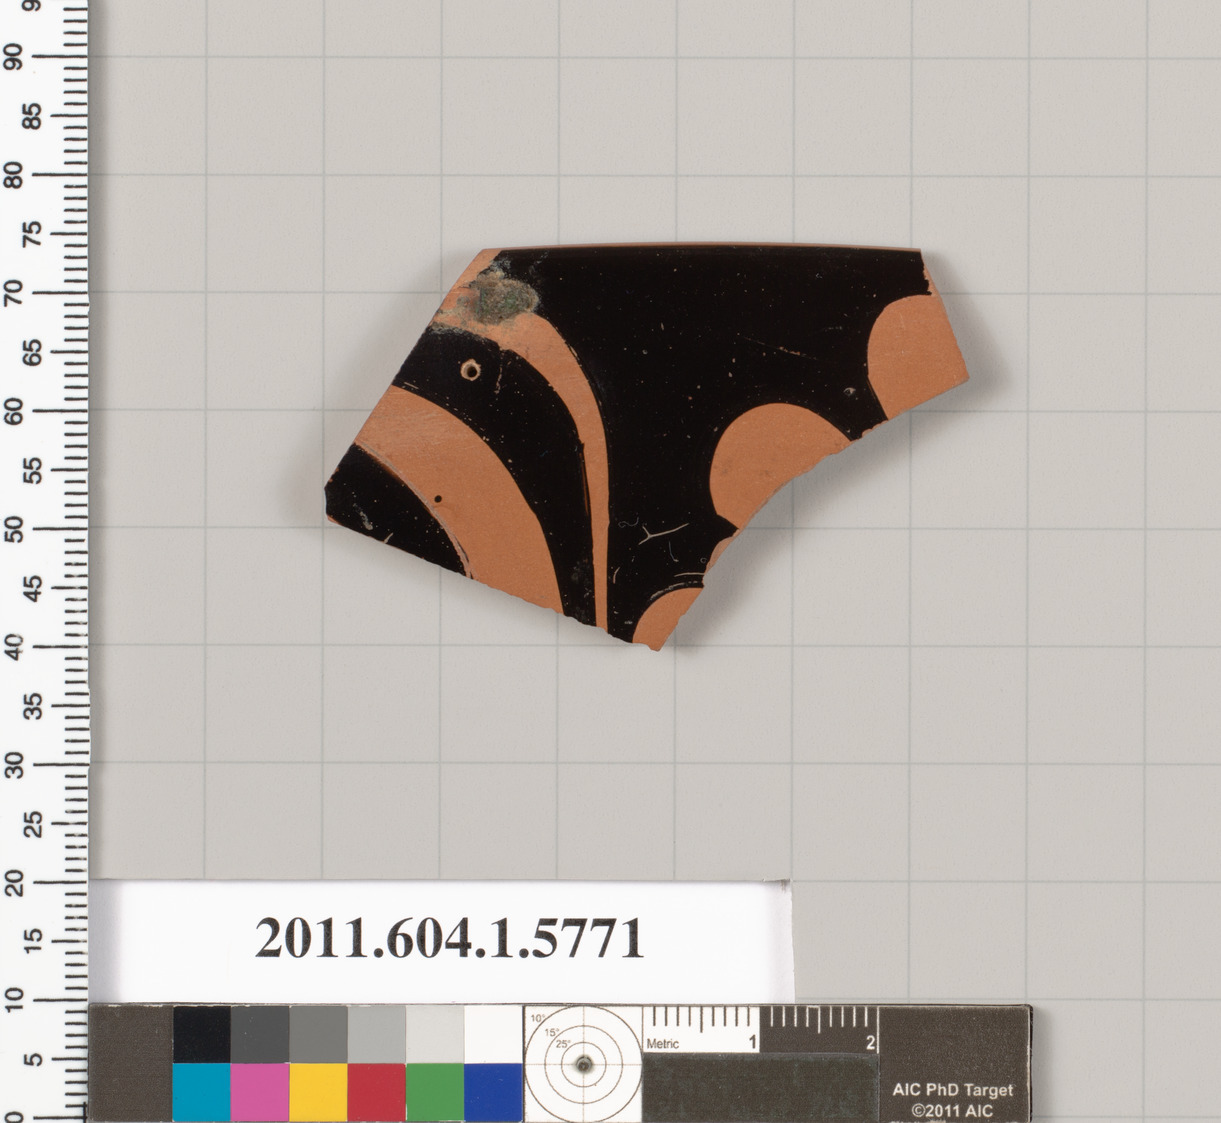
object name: kylix fragment, eye cup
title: Terracotta rim fragment of a kylix: eye-cup (drinking cup)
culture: greek, attic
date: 520-510 BCE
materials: terracotta